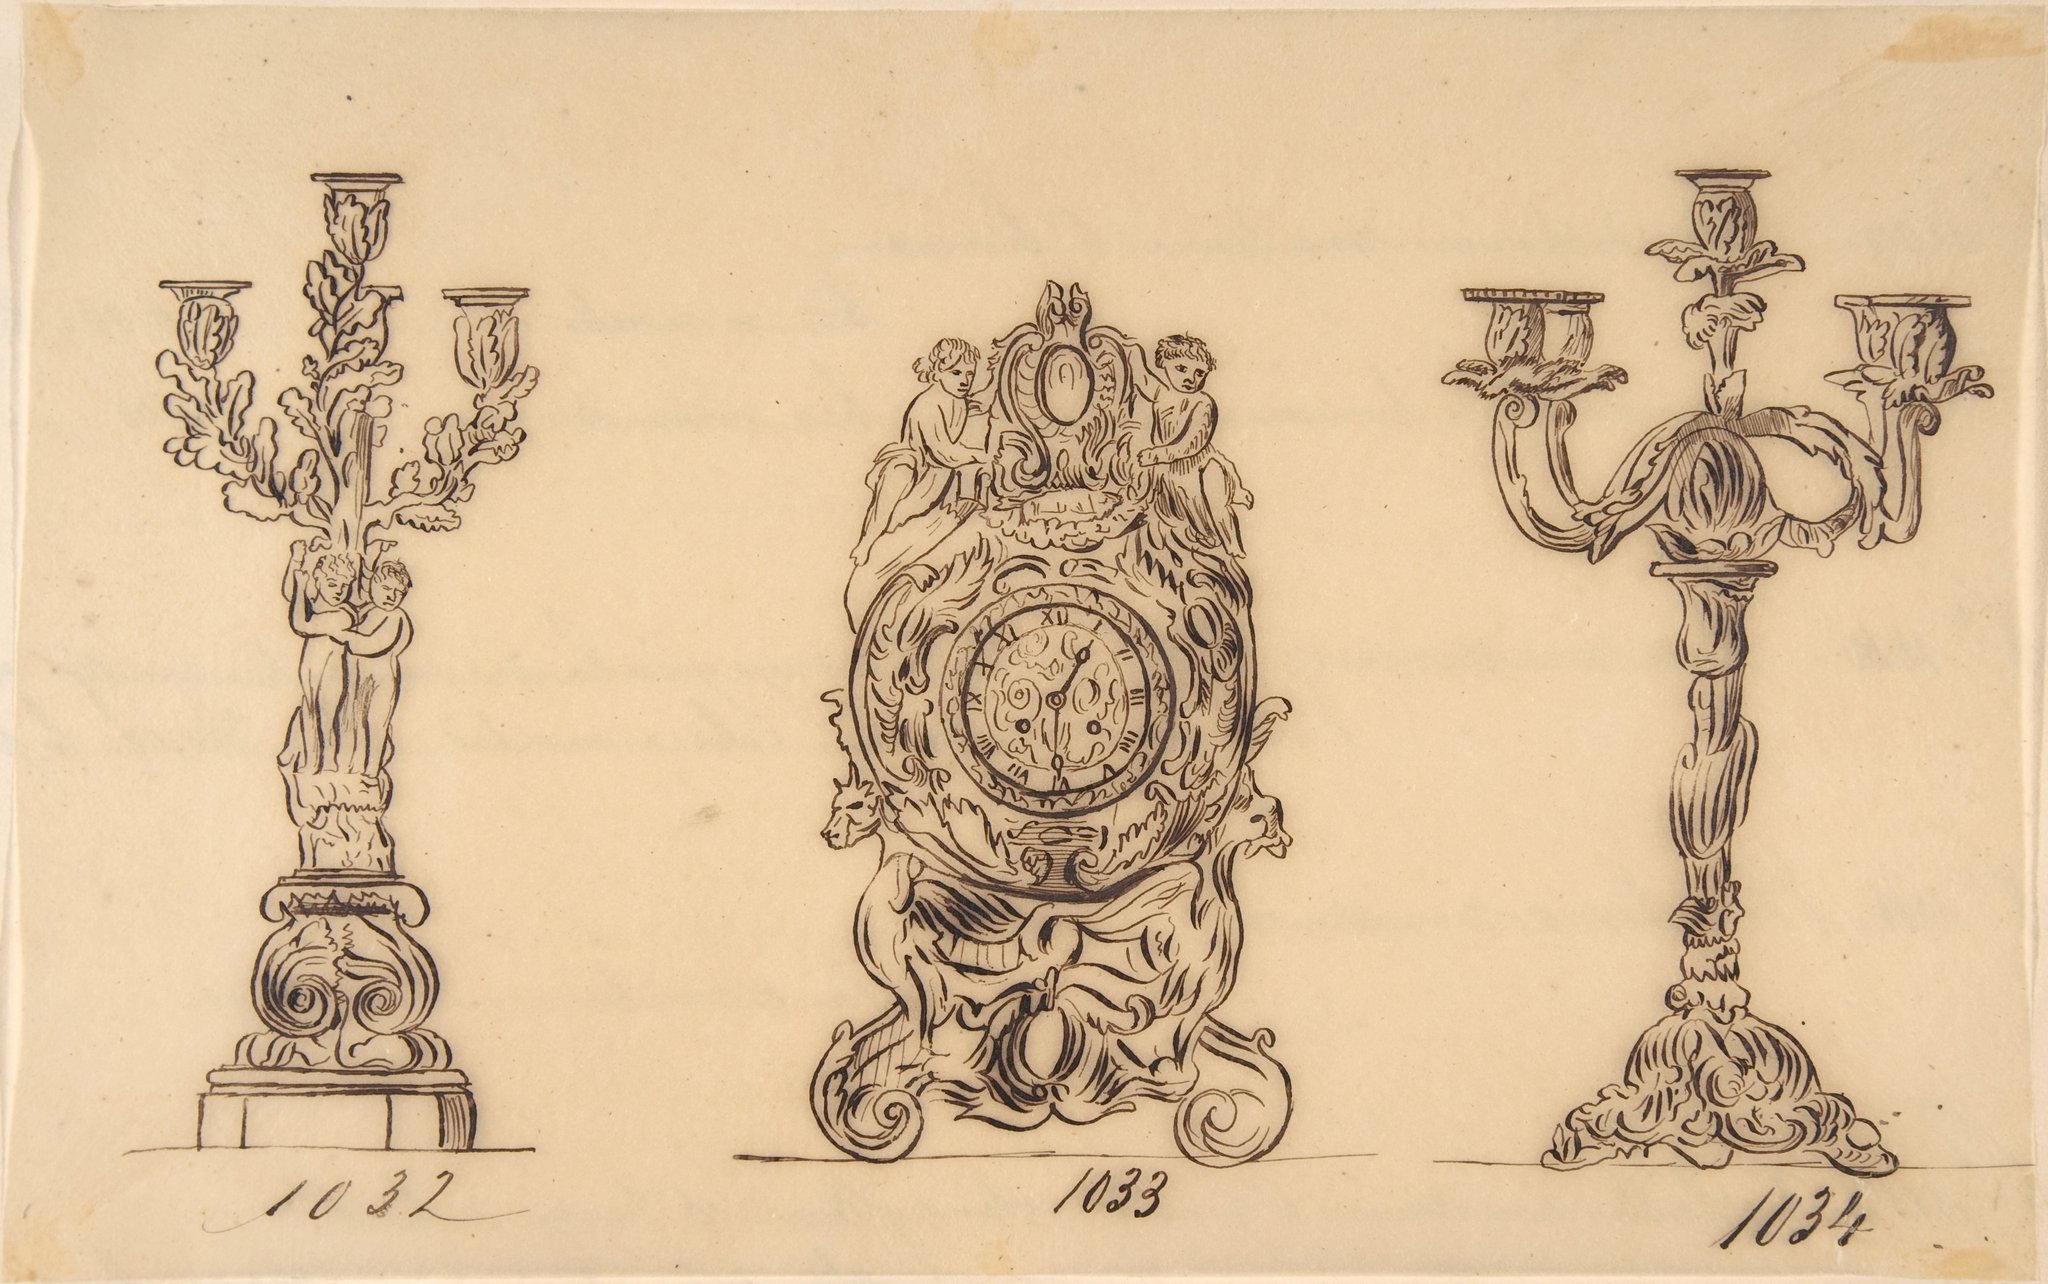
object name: drawing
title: Designs for a Clock and Two Candelabras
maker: anonymous, french, 19th century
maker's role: artist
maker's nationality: french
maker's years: 1800-1900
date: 1801-1900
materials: ink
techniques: pen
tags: clocks,candelabra